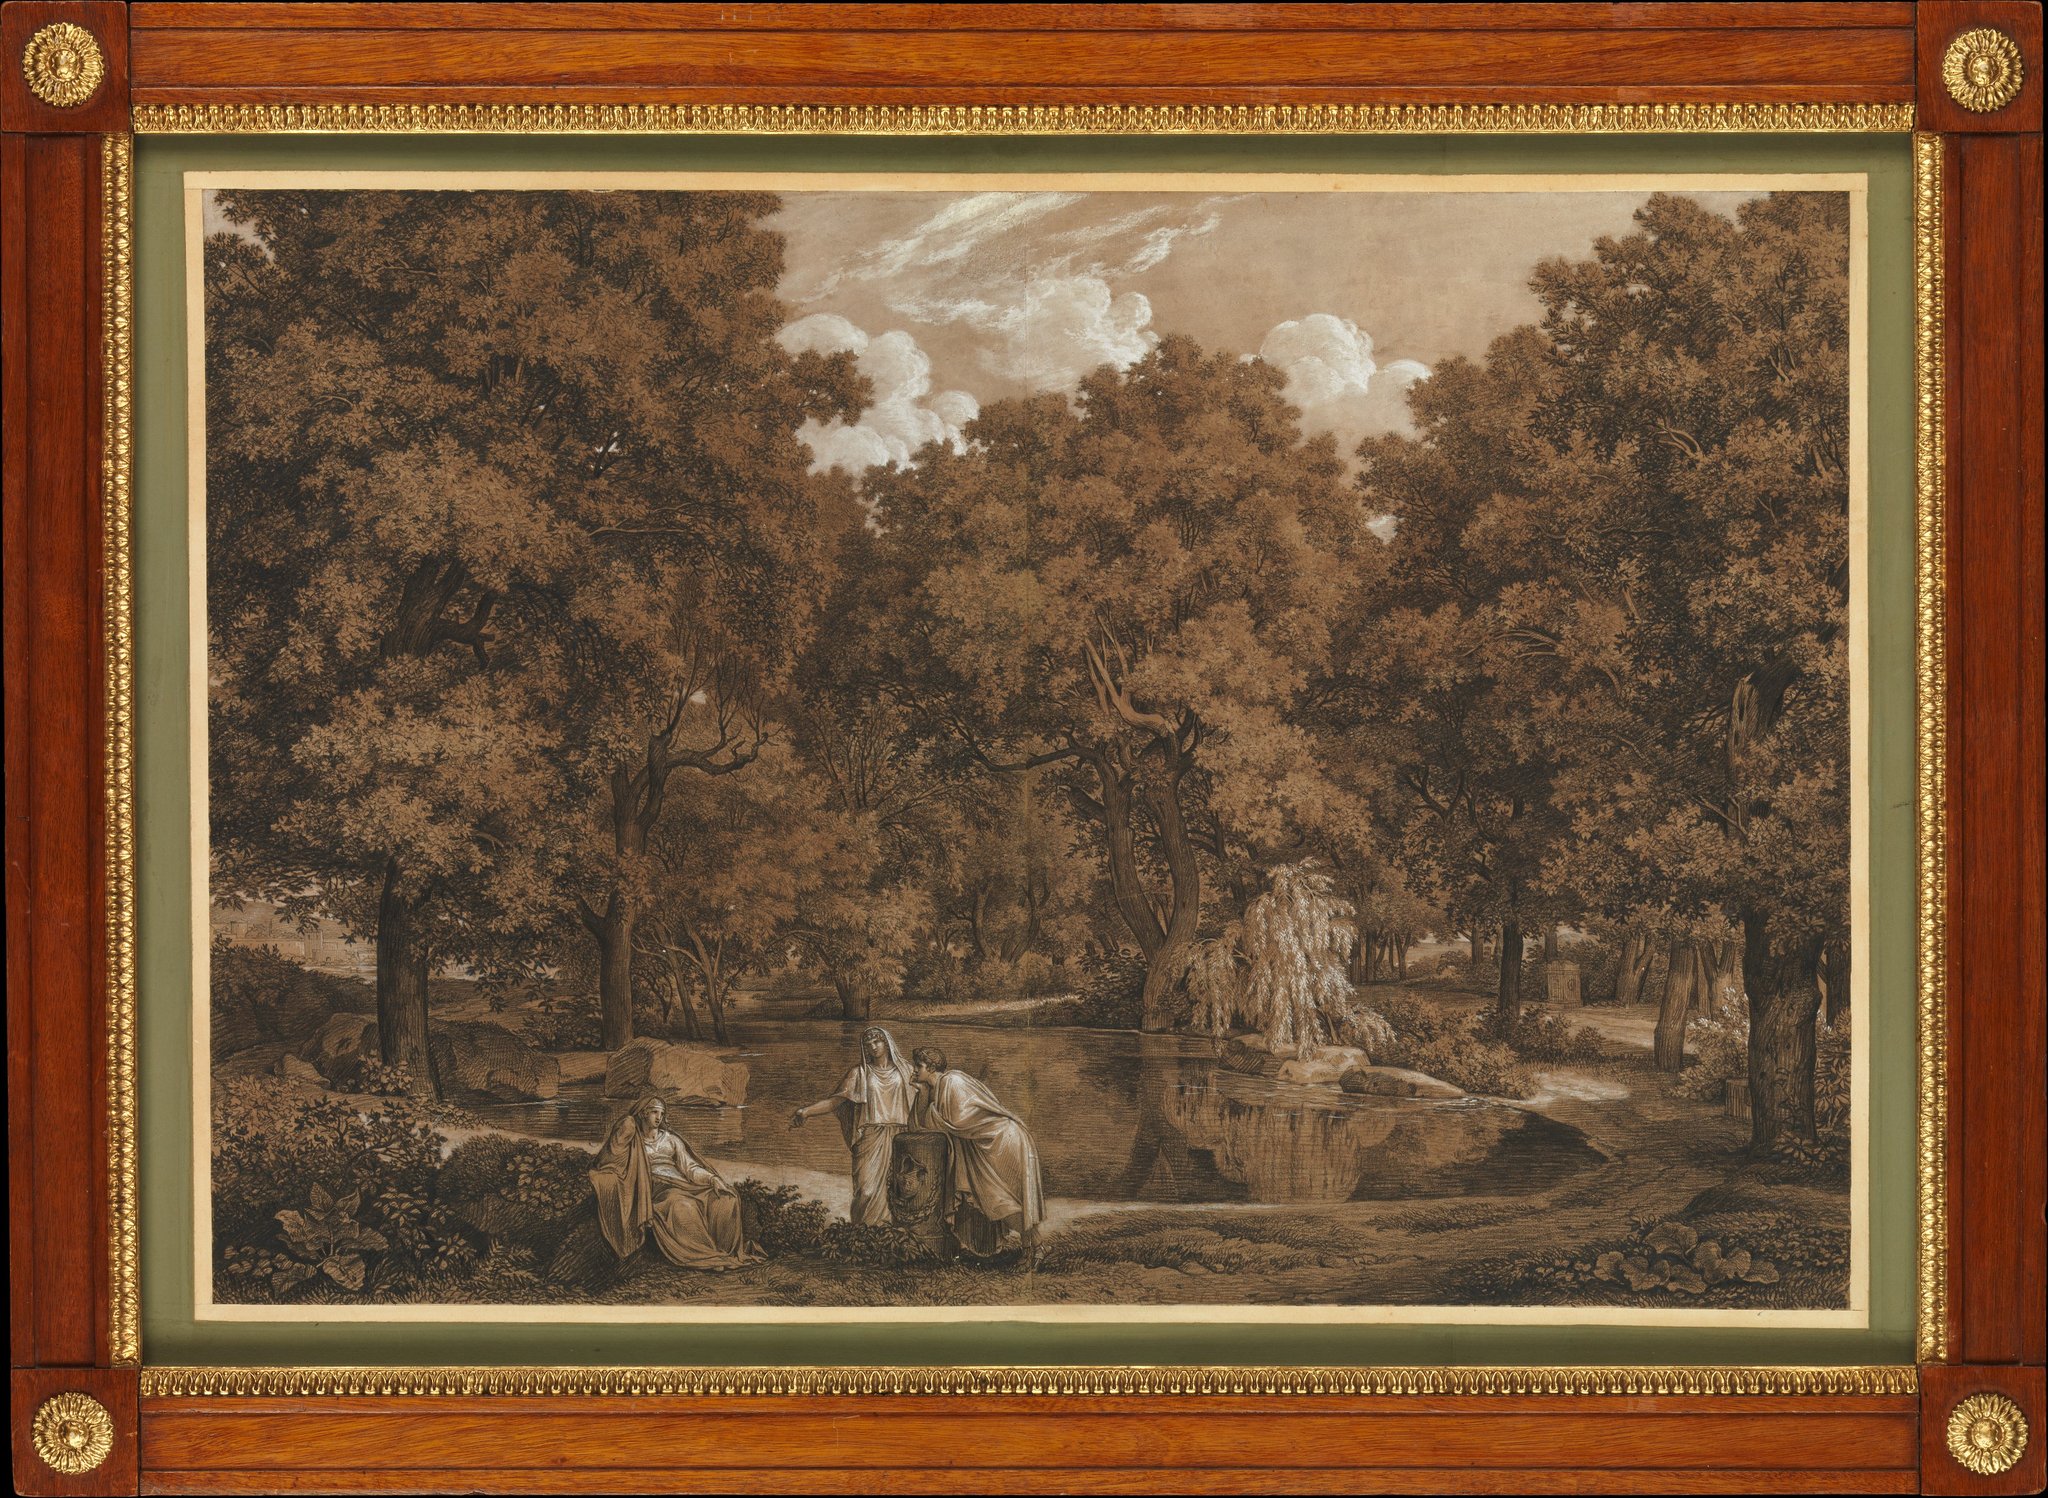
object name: drawing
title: Arcadian Landscape with Three Figures at a Lake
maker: johann christian reinhart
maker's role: artist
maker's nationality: german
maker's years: 1761-1847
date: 1792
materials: chalk, gouache, paper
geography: germany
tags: men,women,lakes,landscapes